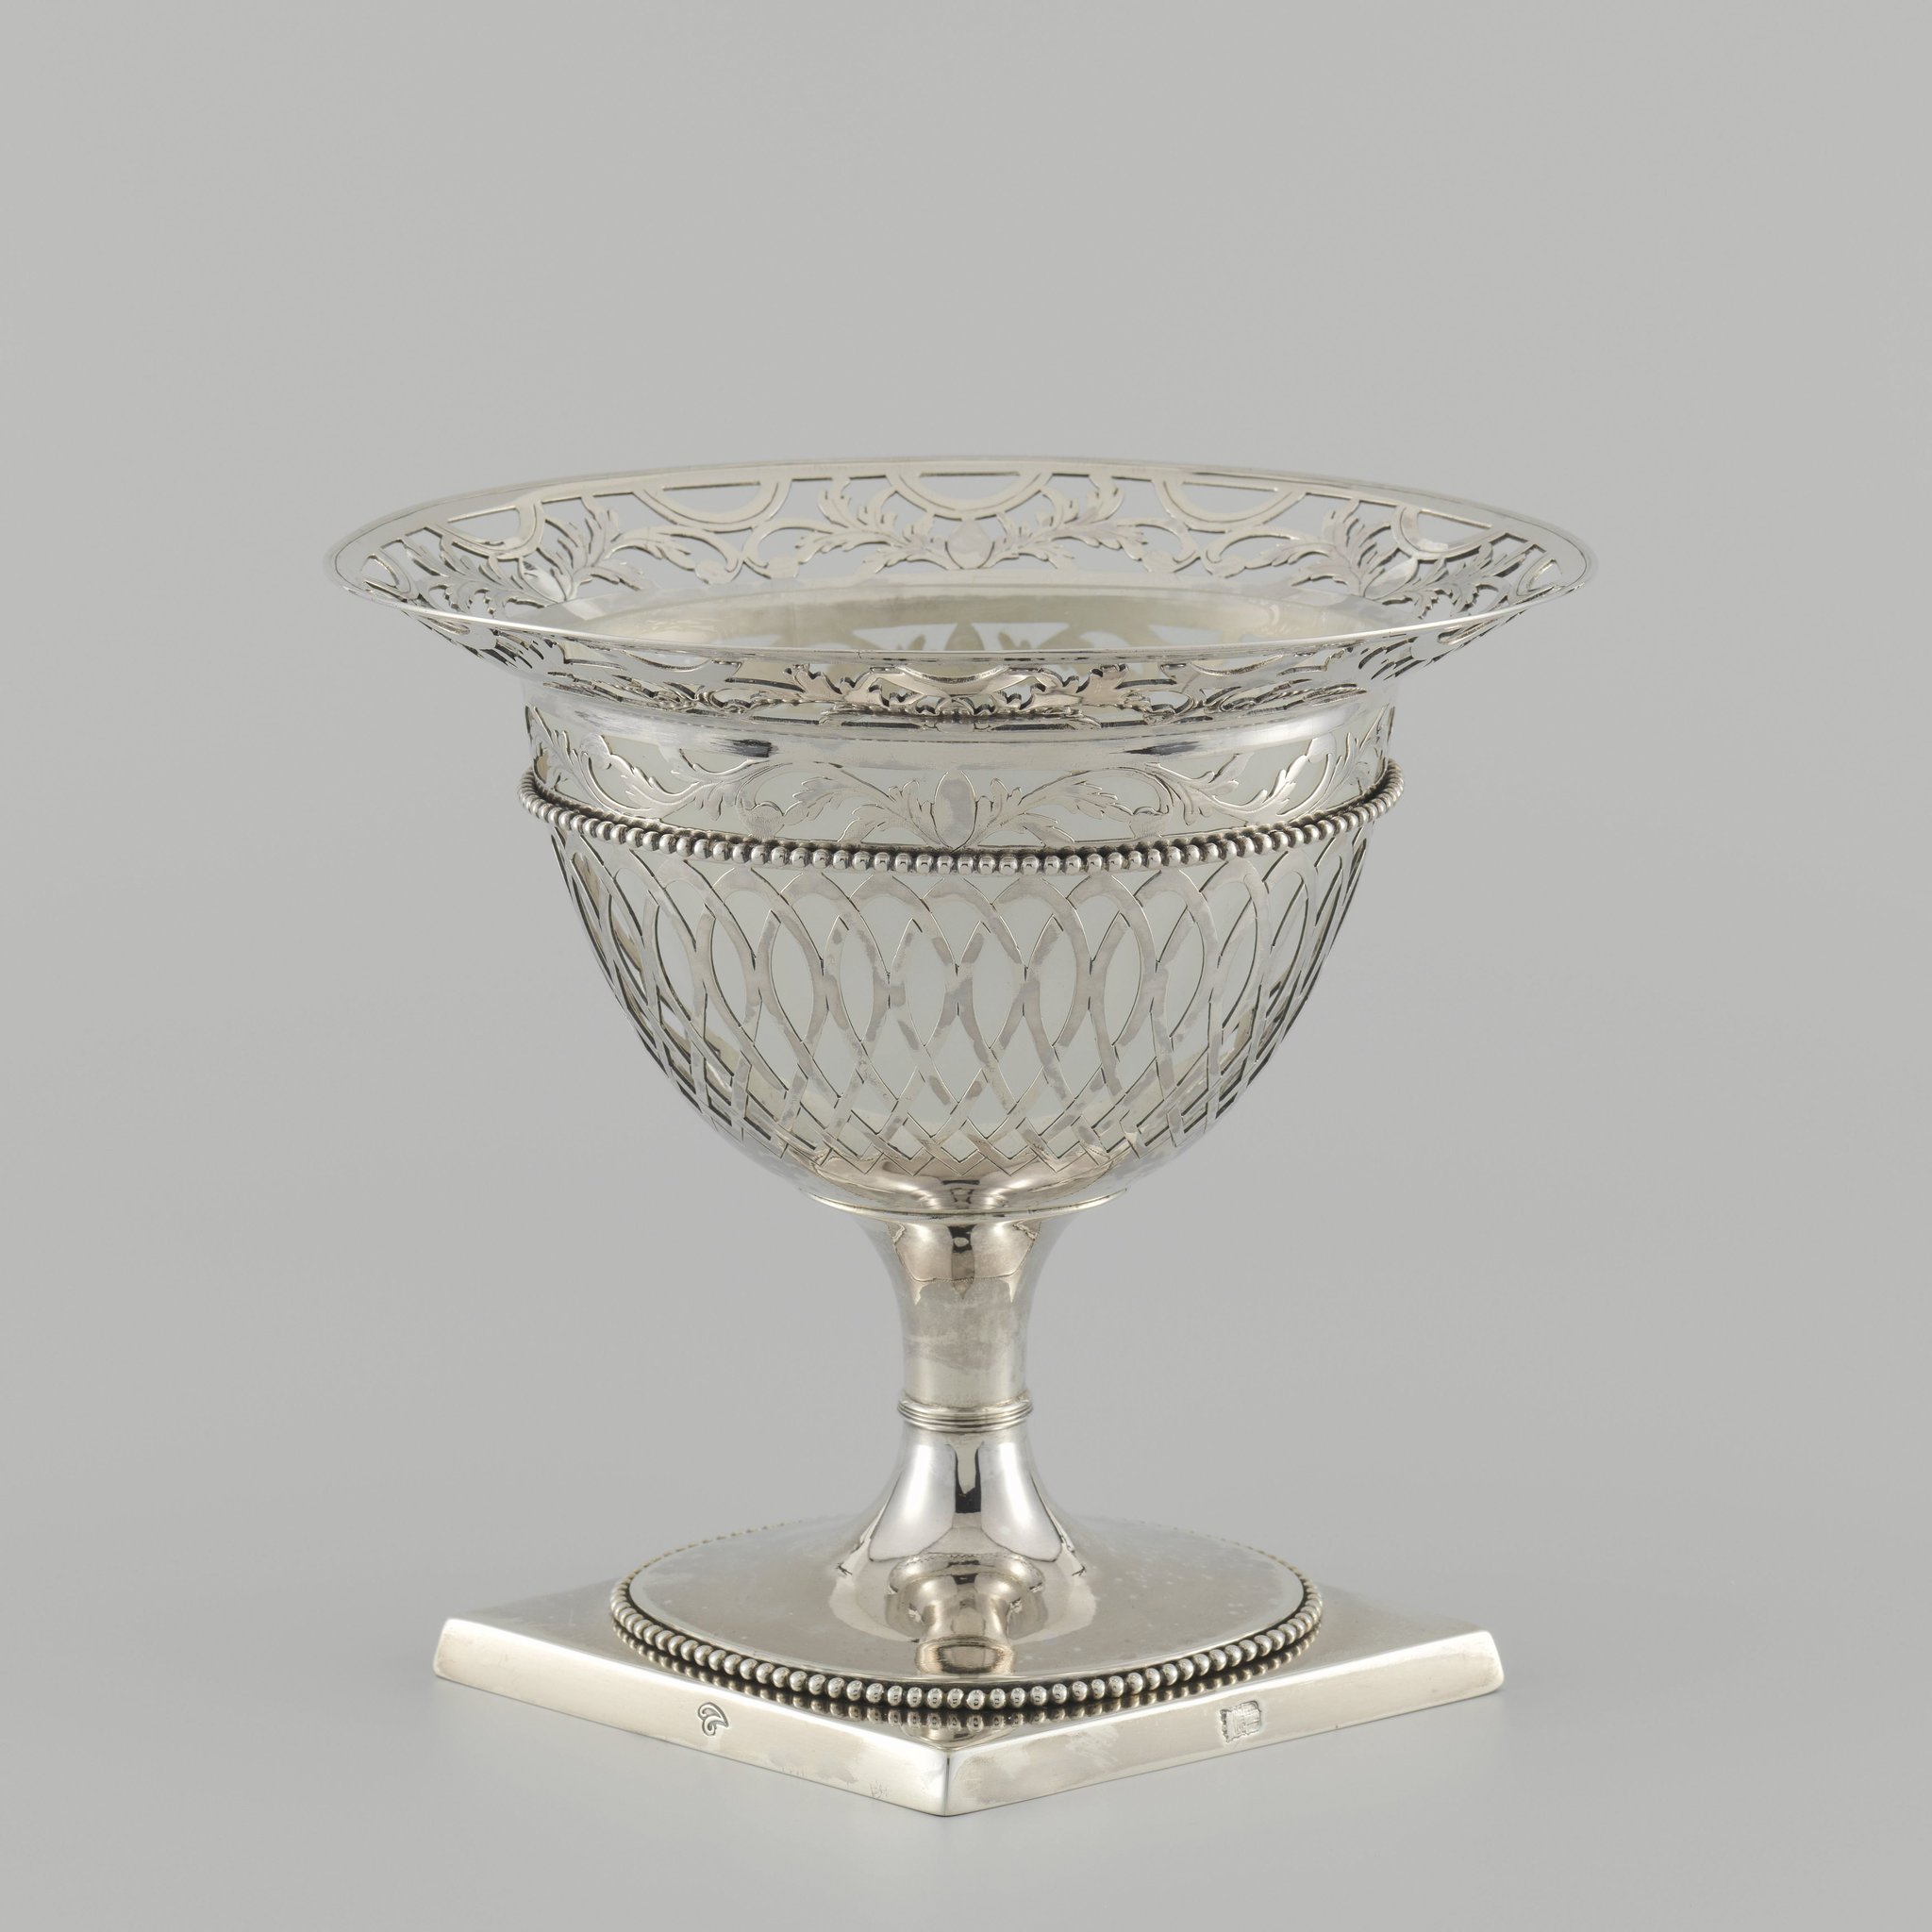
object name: spoon holder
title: Lepelvaasje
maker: cornelis knuysting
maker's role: silversmith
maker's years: 1730-1812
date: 1802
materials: silver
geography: rotterdam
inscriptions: town mark, date letter: ‘V’, maker's mark, alloy mark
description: Lepelvaas van zilver. De ovale vaas rust op een ruitvormige plint. De kelkvormige bak heeft een opengewerkte decoratie. De schuin opstaande rand wordt onderbroken door 12 segmentvormige reserves waarin de lepels kunnen hangen.